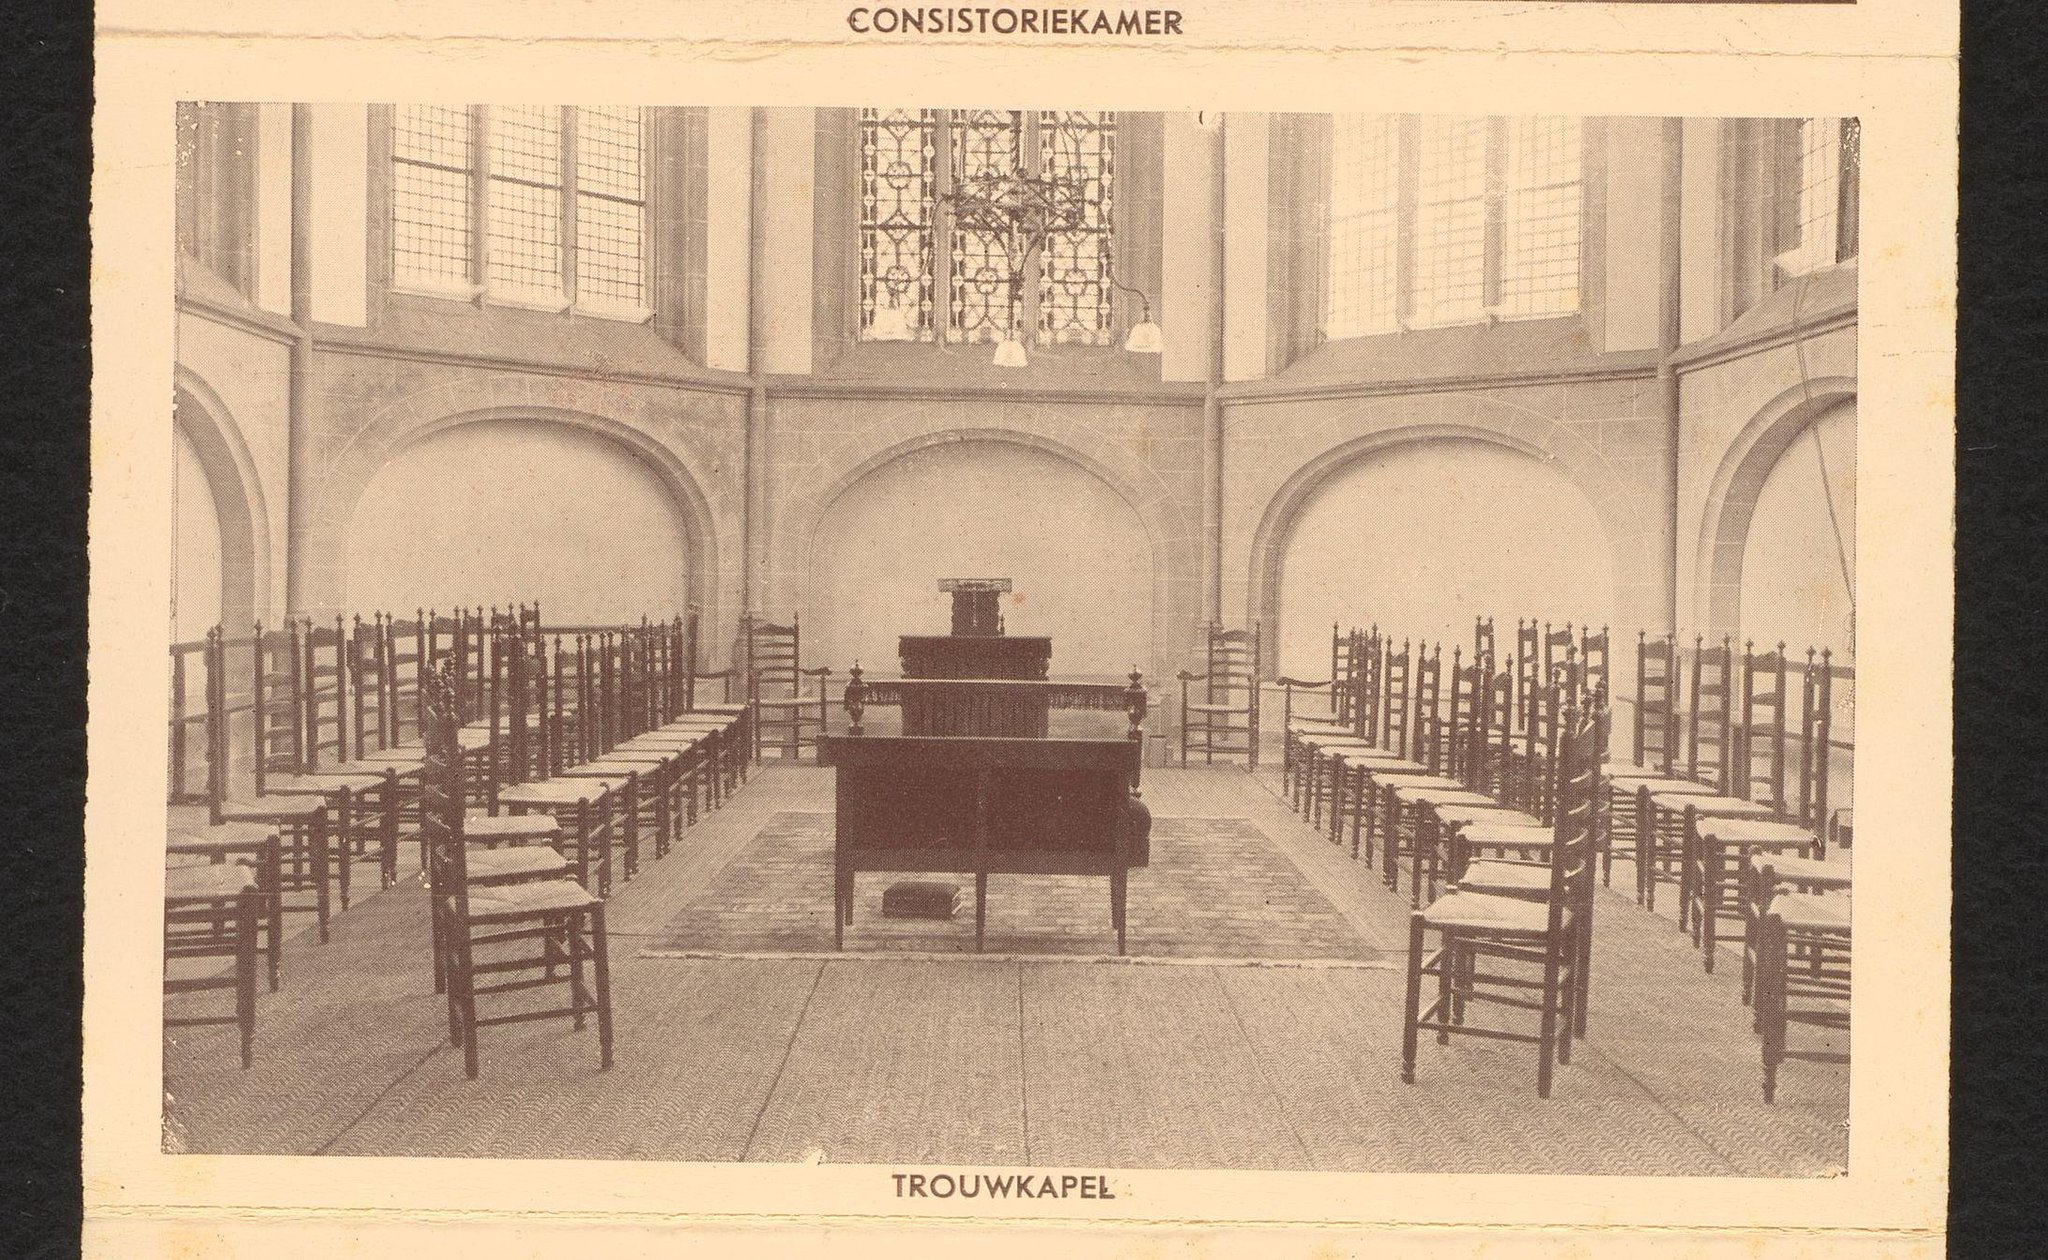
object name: photomechanical print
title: Trouwkapel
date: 1925-1940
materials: cardboard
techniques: autotype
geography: zutphen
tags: parts of church interior: chapel